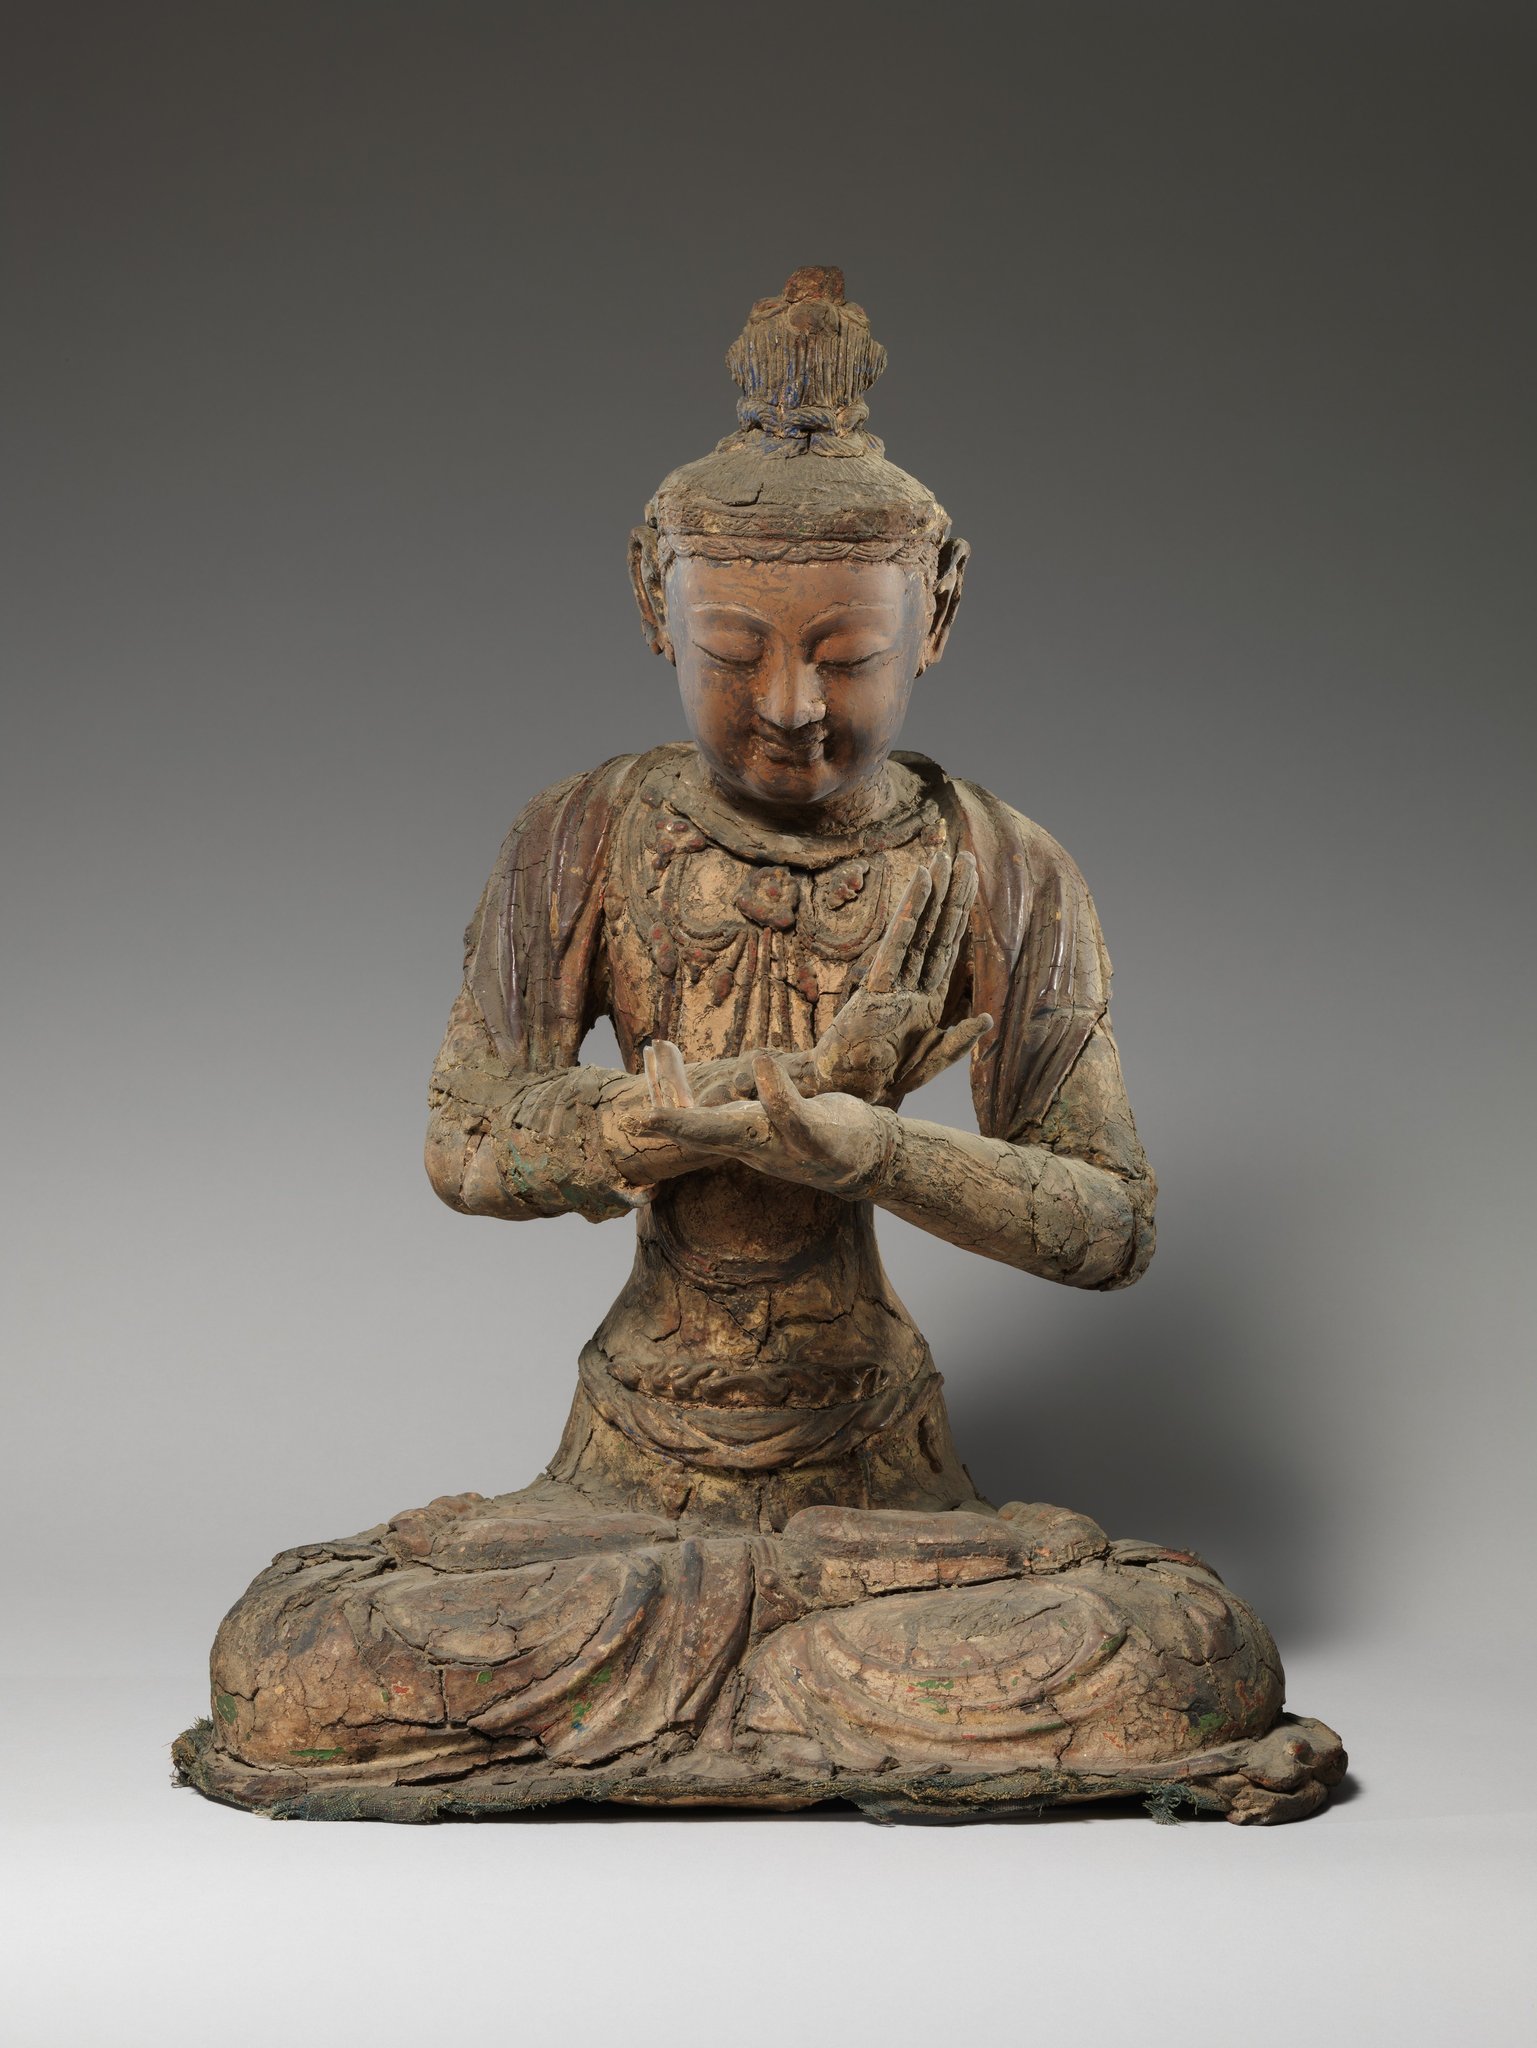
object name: figure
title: Seated Bodhisattva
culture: chinese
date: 1368-1644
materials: lacquer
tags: bodhisattvas